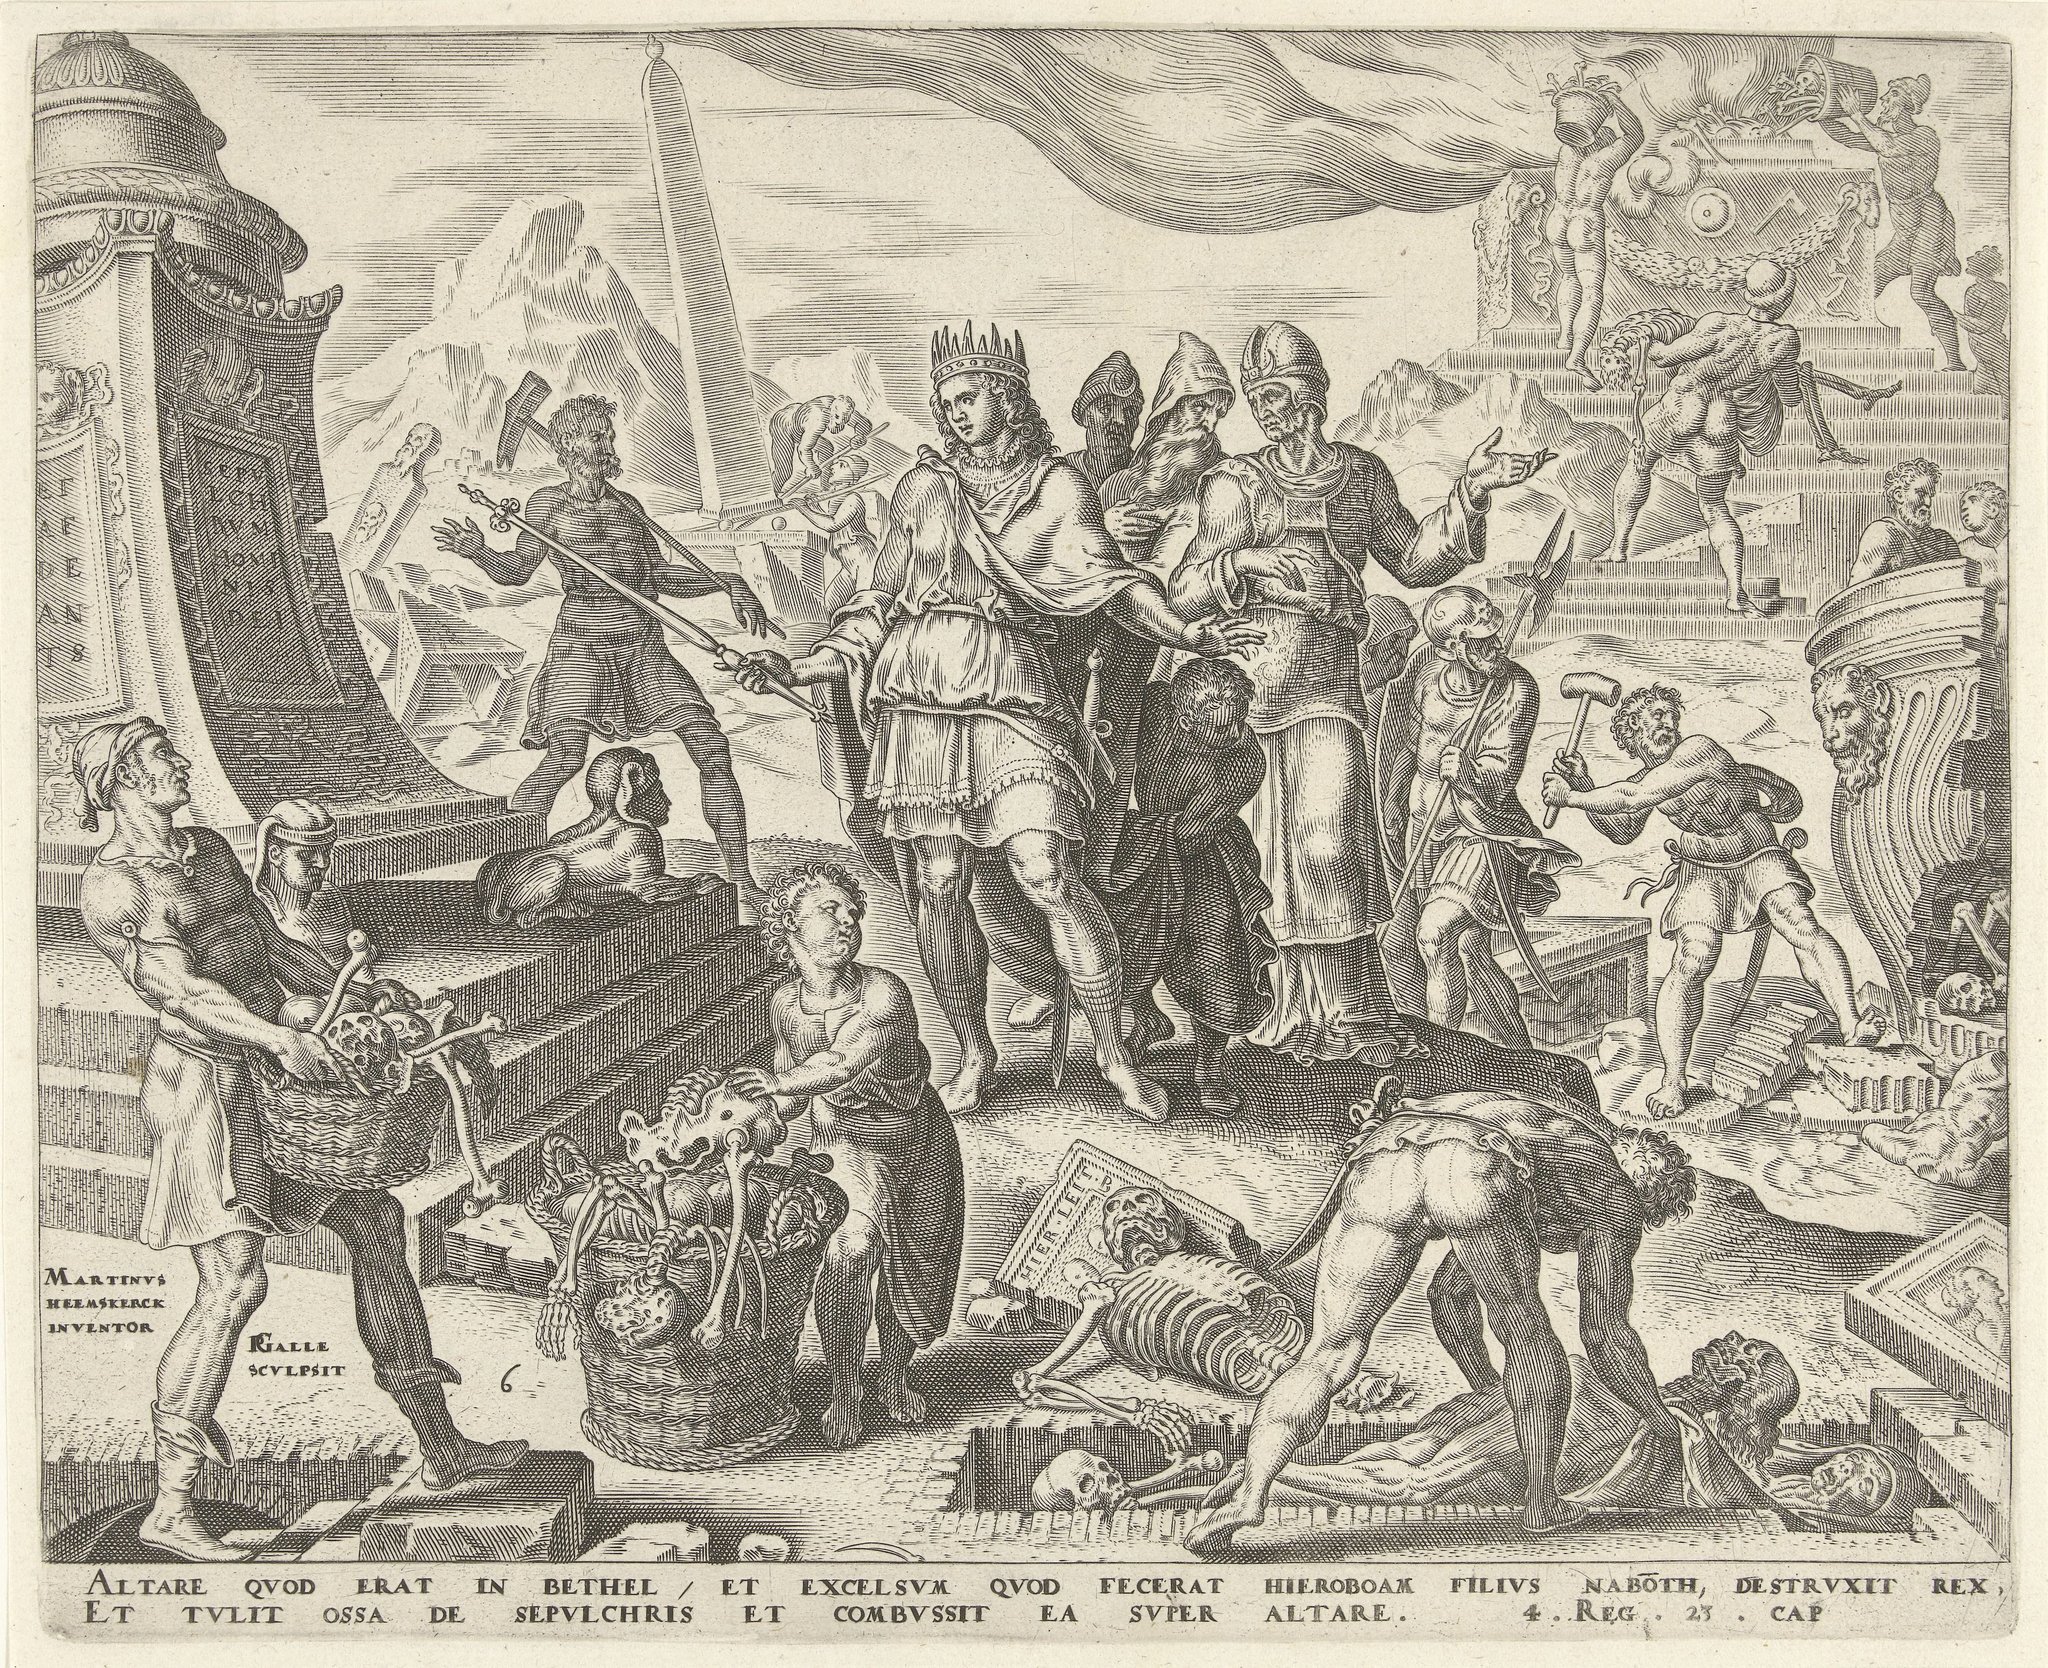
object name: print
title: Geschiedenis van koning Josia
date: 1569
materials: paper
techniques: engraving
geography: haarlem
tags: the altar at bethel is desecrated: bones taken out of some nearby tombs are burnt on the altar (the tomb of the prophet of judah is spared) ~ story of josiah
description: Koning Josia laat de graven rond de offerplaats in Betel plunderen en de beenderen verbranden op het altaar. Voor het graf van de profeet uit Juda blijft hij staan. Dit graf blijft gespaard.